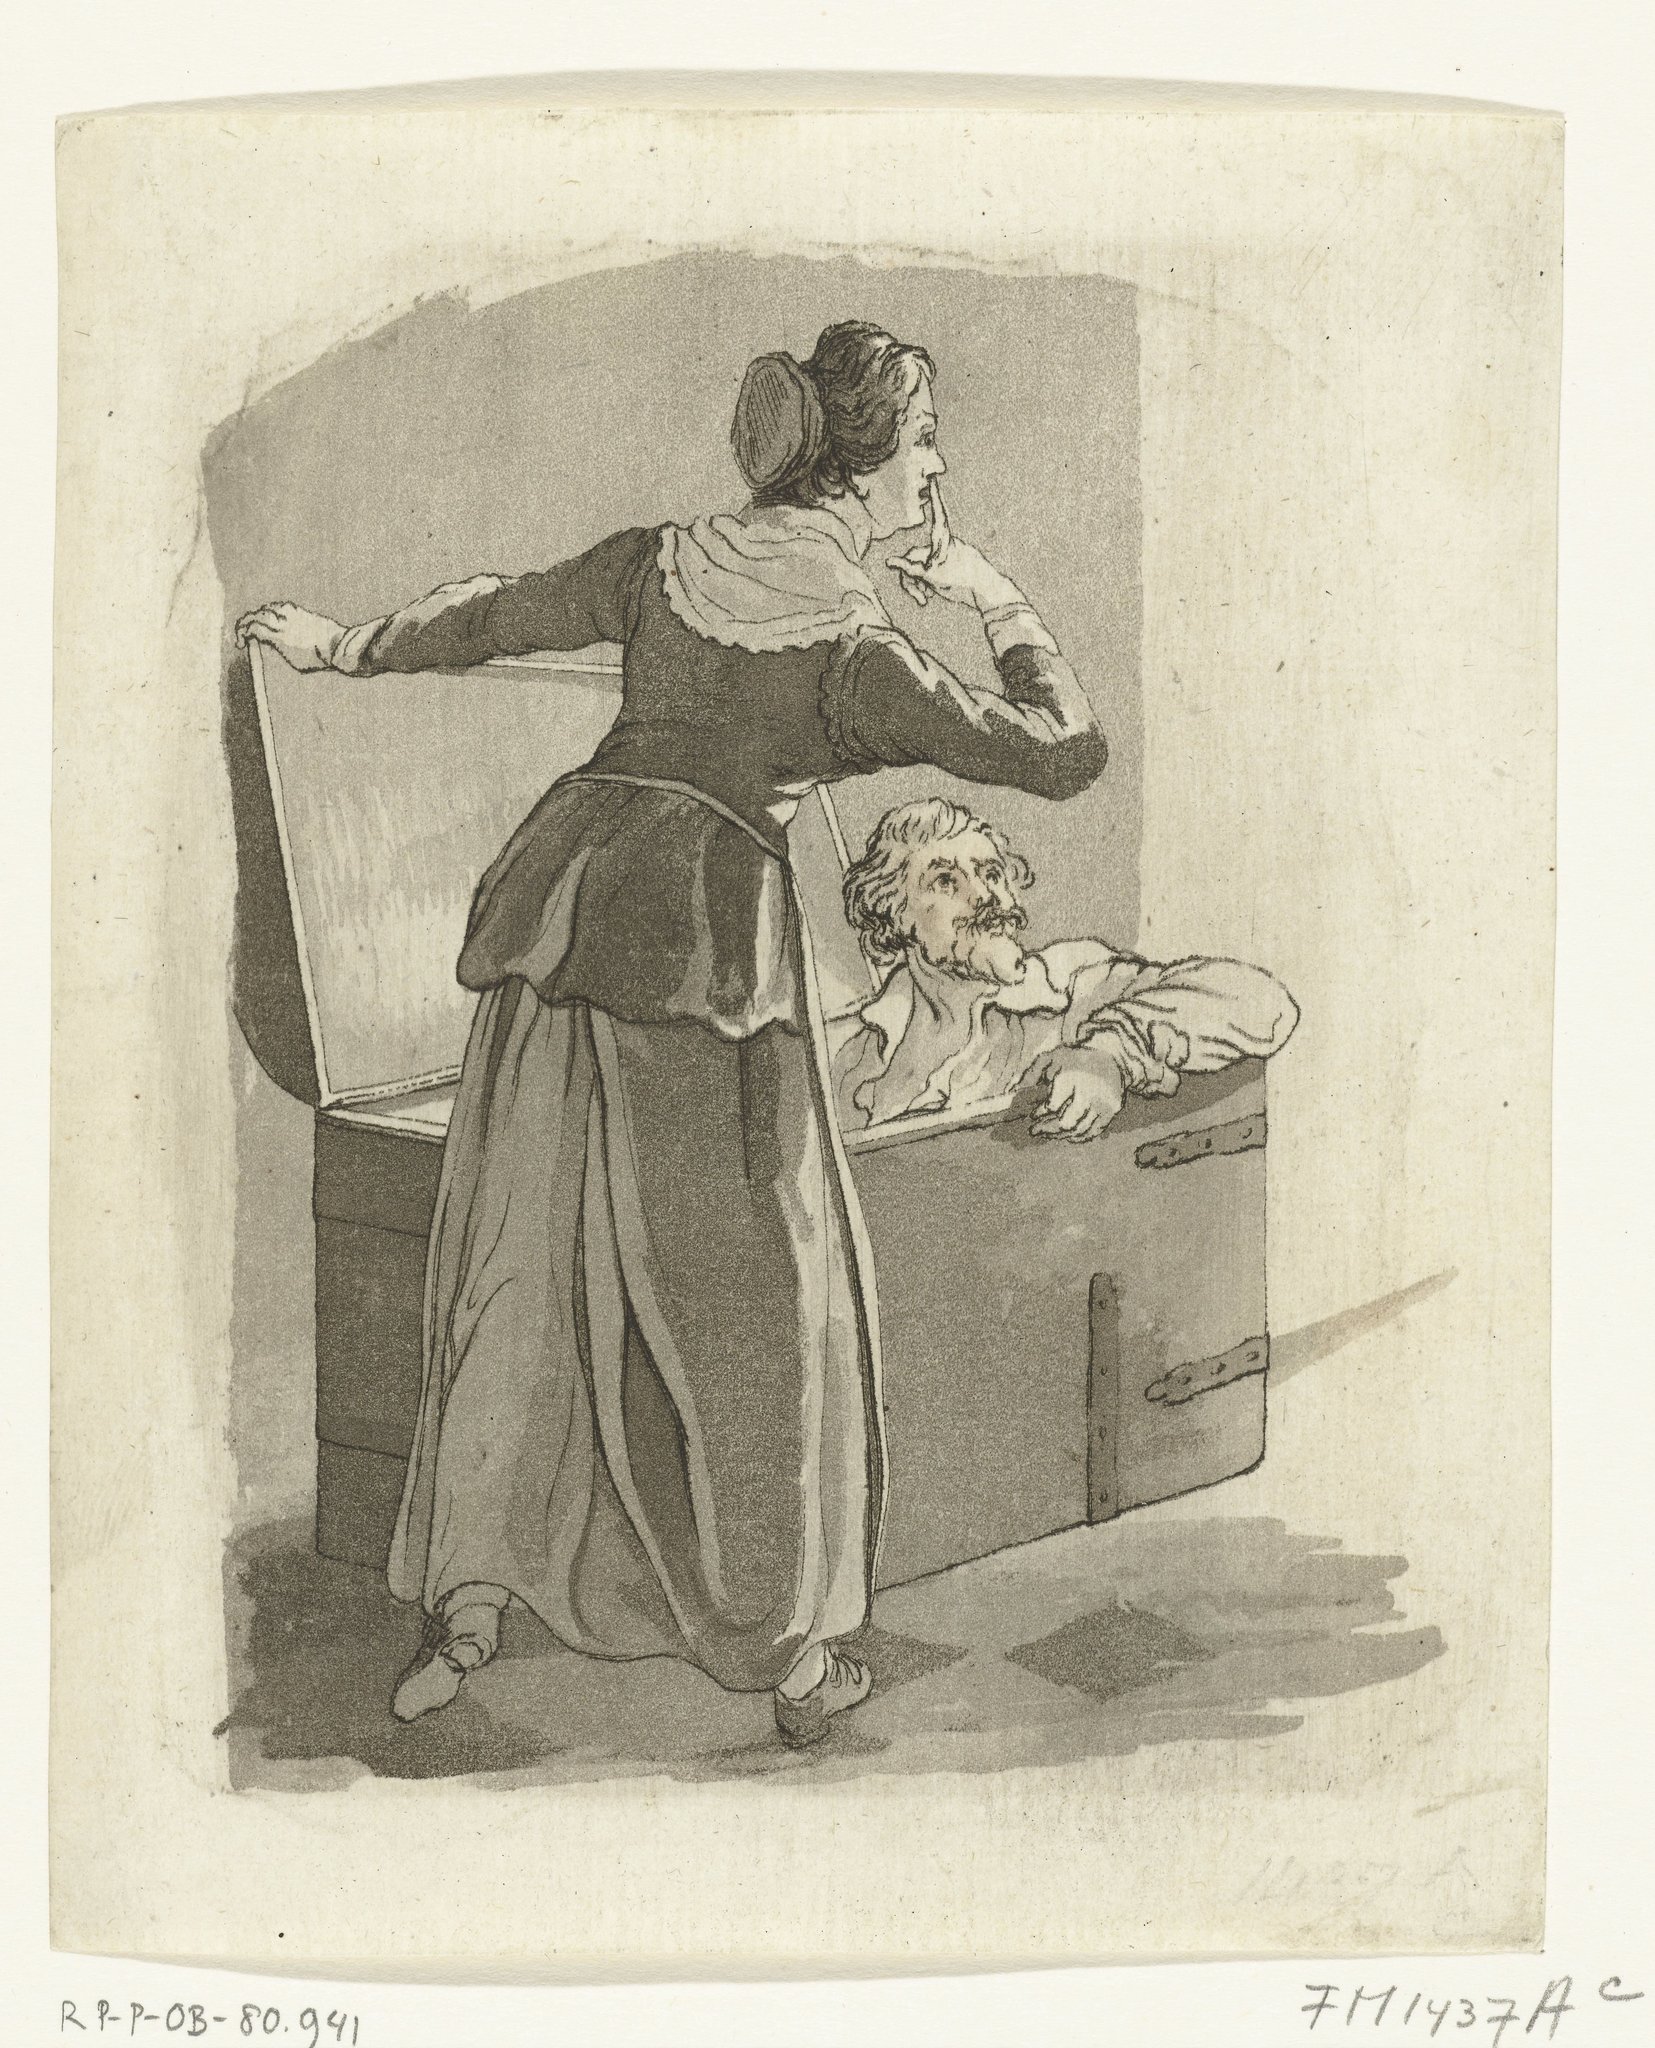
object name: print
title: Elsje van Houweningen betrapt Hugo de Groot in de boekenkist (detail), 1621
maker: pieter barbiers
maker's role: draughtsman, painter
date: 1800-1824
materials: paper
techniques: aquatint, etching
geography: netherlands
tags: delft, hugo de groot, the hague, law and jurisprudence (+ escape from prison), loevestein castle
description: Detail van de voorstelling van dienstmeid Elsje van Houweningen die Hugo de Groot betrapt wanneer hij, geholpen door zijn vrouw Maria van Reigersberch, de boekenkist uitprobeert, maart 1621. Van Reigersberch had het plan voor de ontsnapping met de boekenkist bedacht en Van Houweningen zou een grote rol spelen in de uiteindelijke uitvoering ervan.